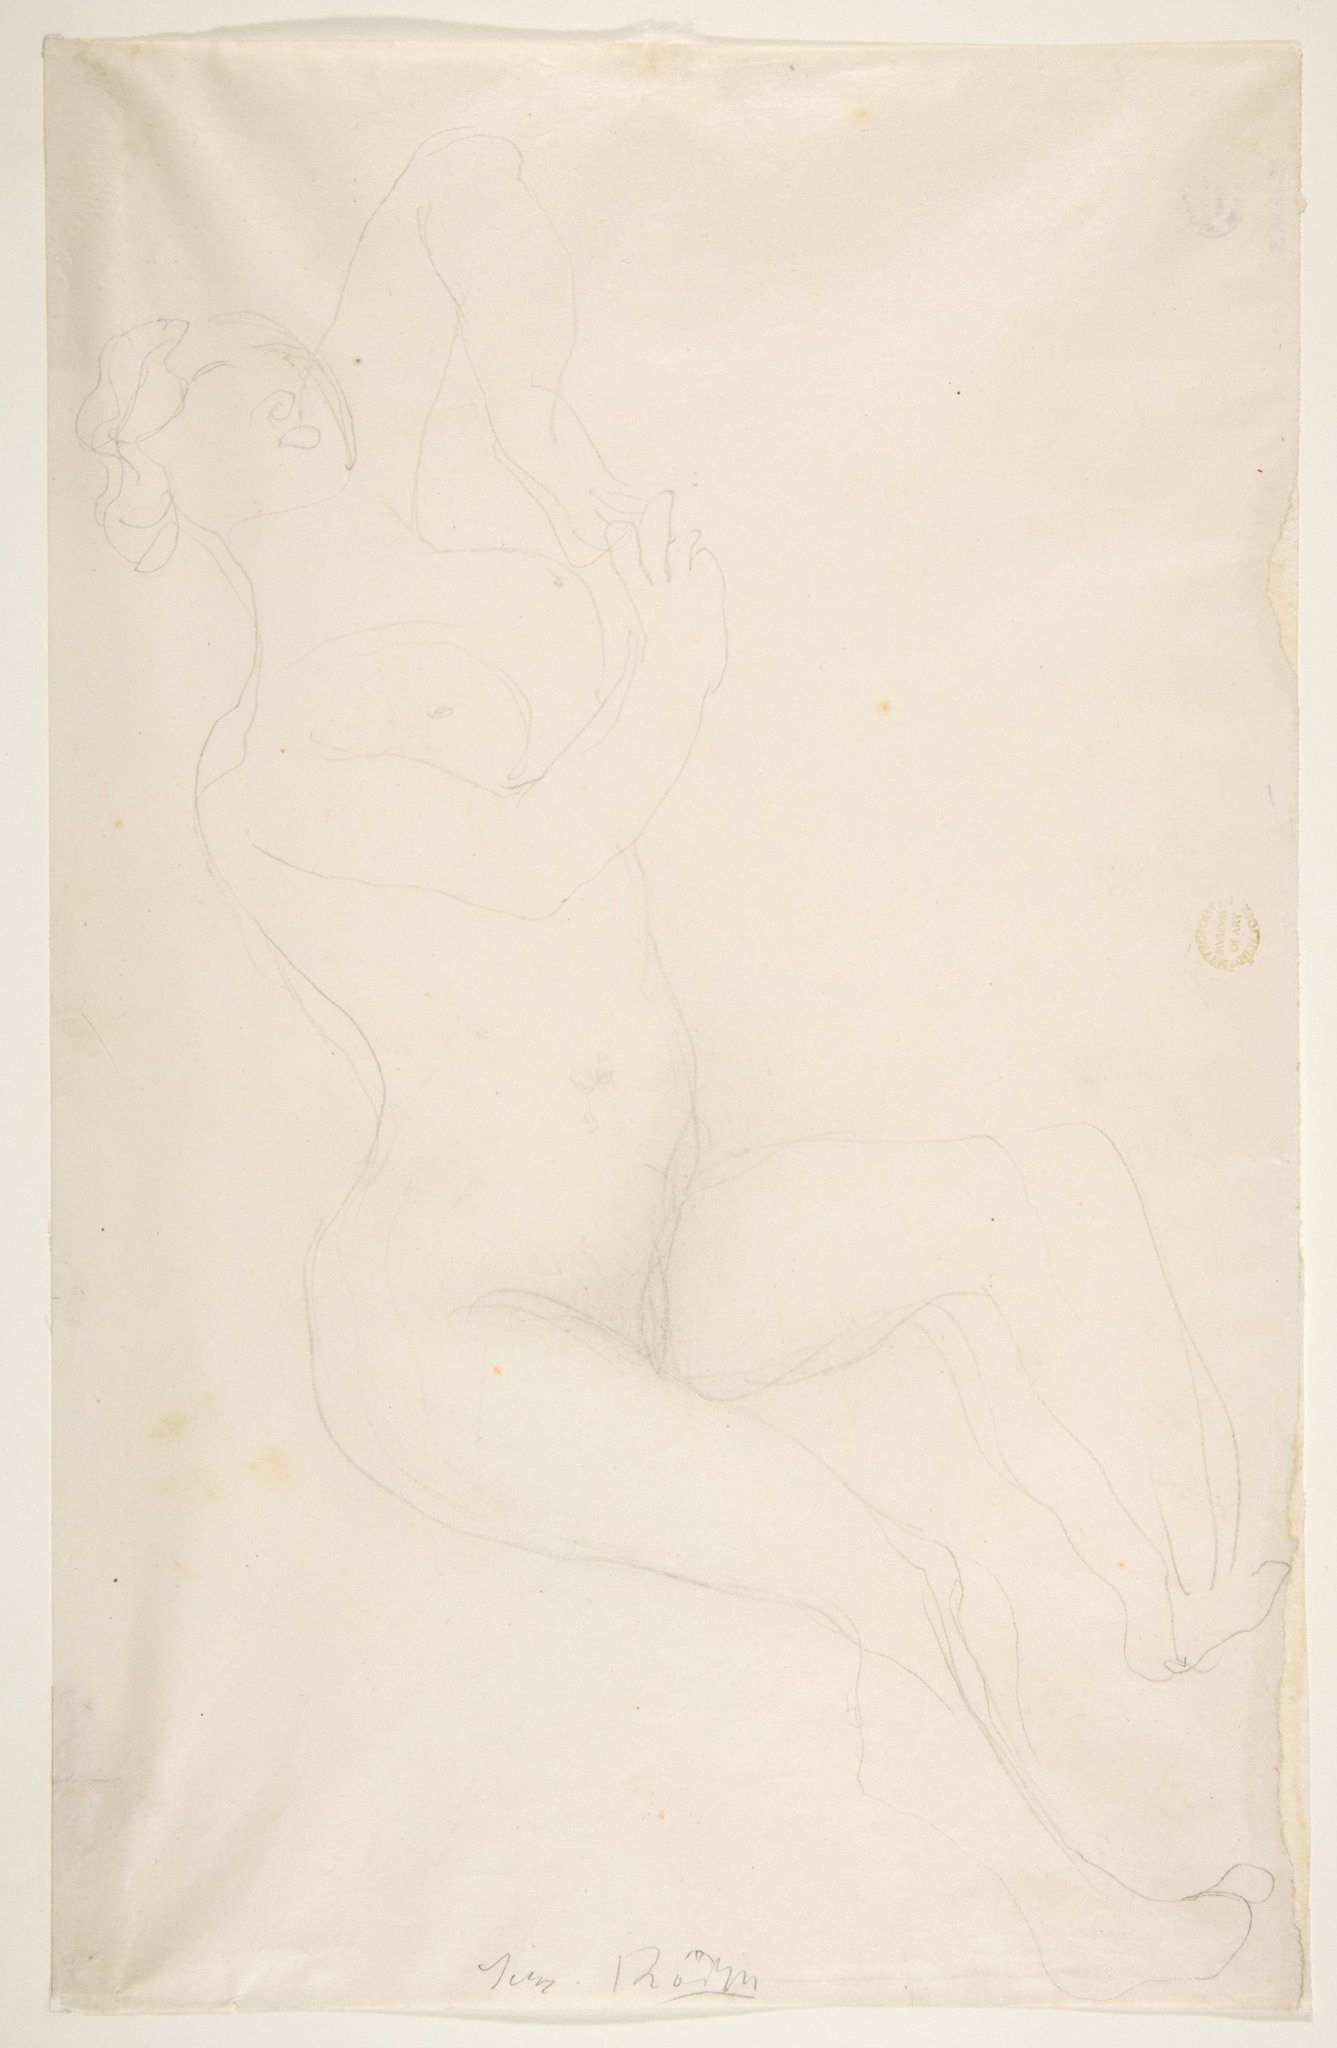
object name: drawing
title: Reclining nude female figure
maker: auguste rodin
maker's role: artist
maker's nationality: french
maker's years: 1840-1917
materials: graphite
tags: female nudes